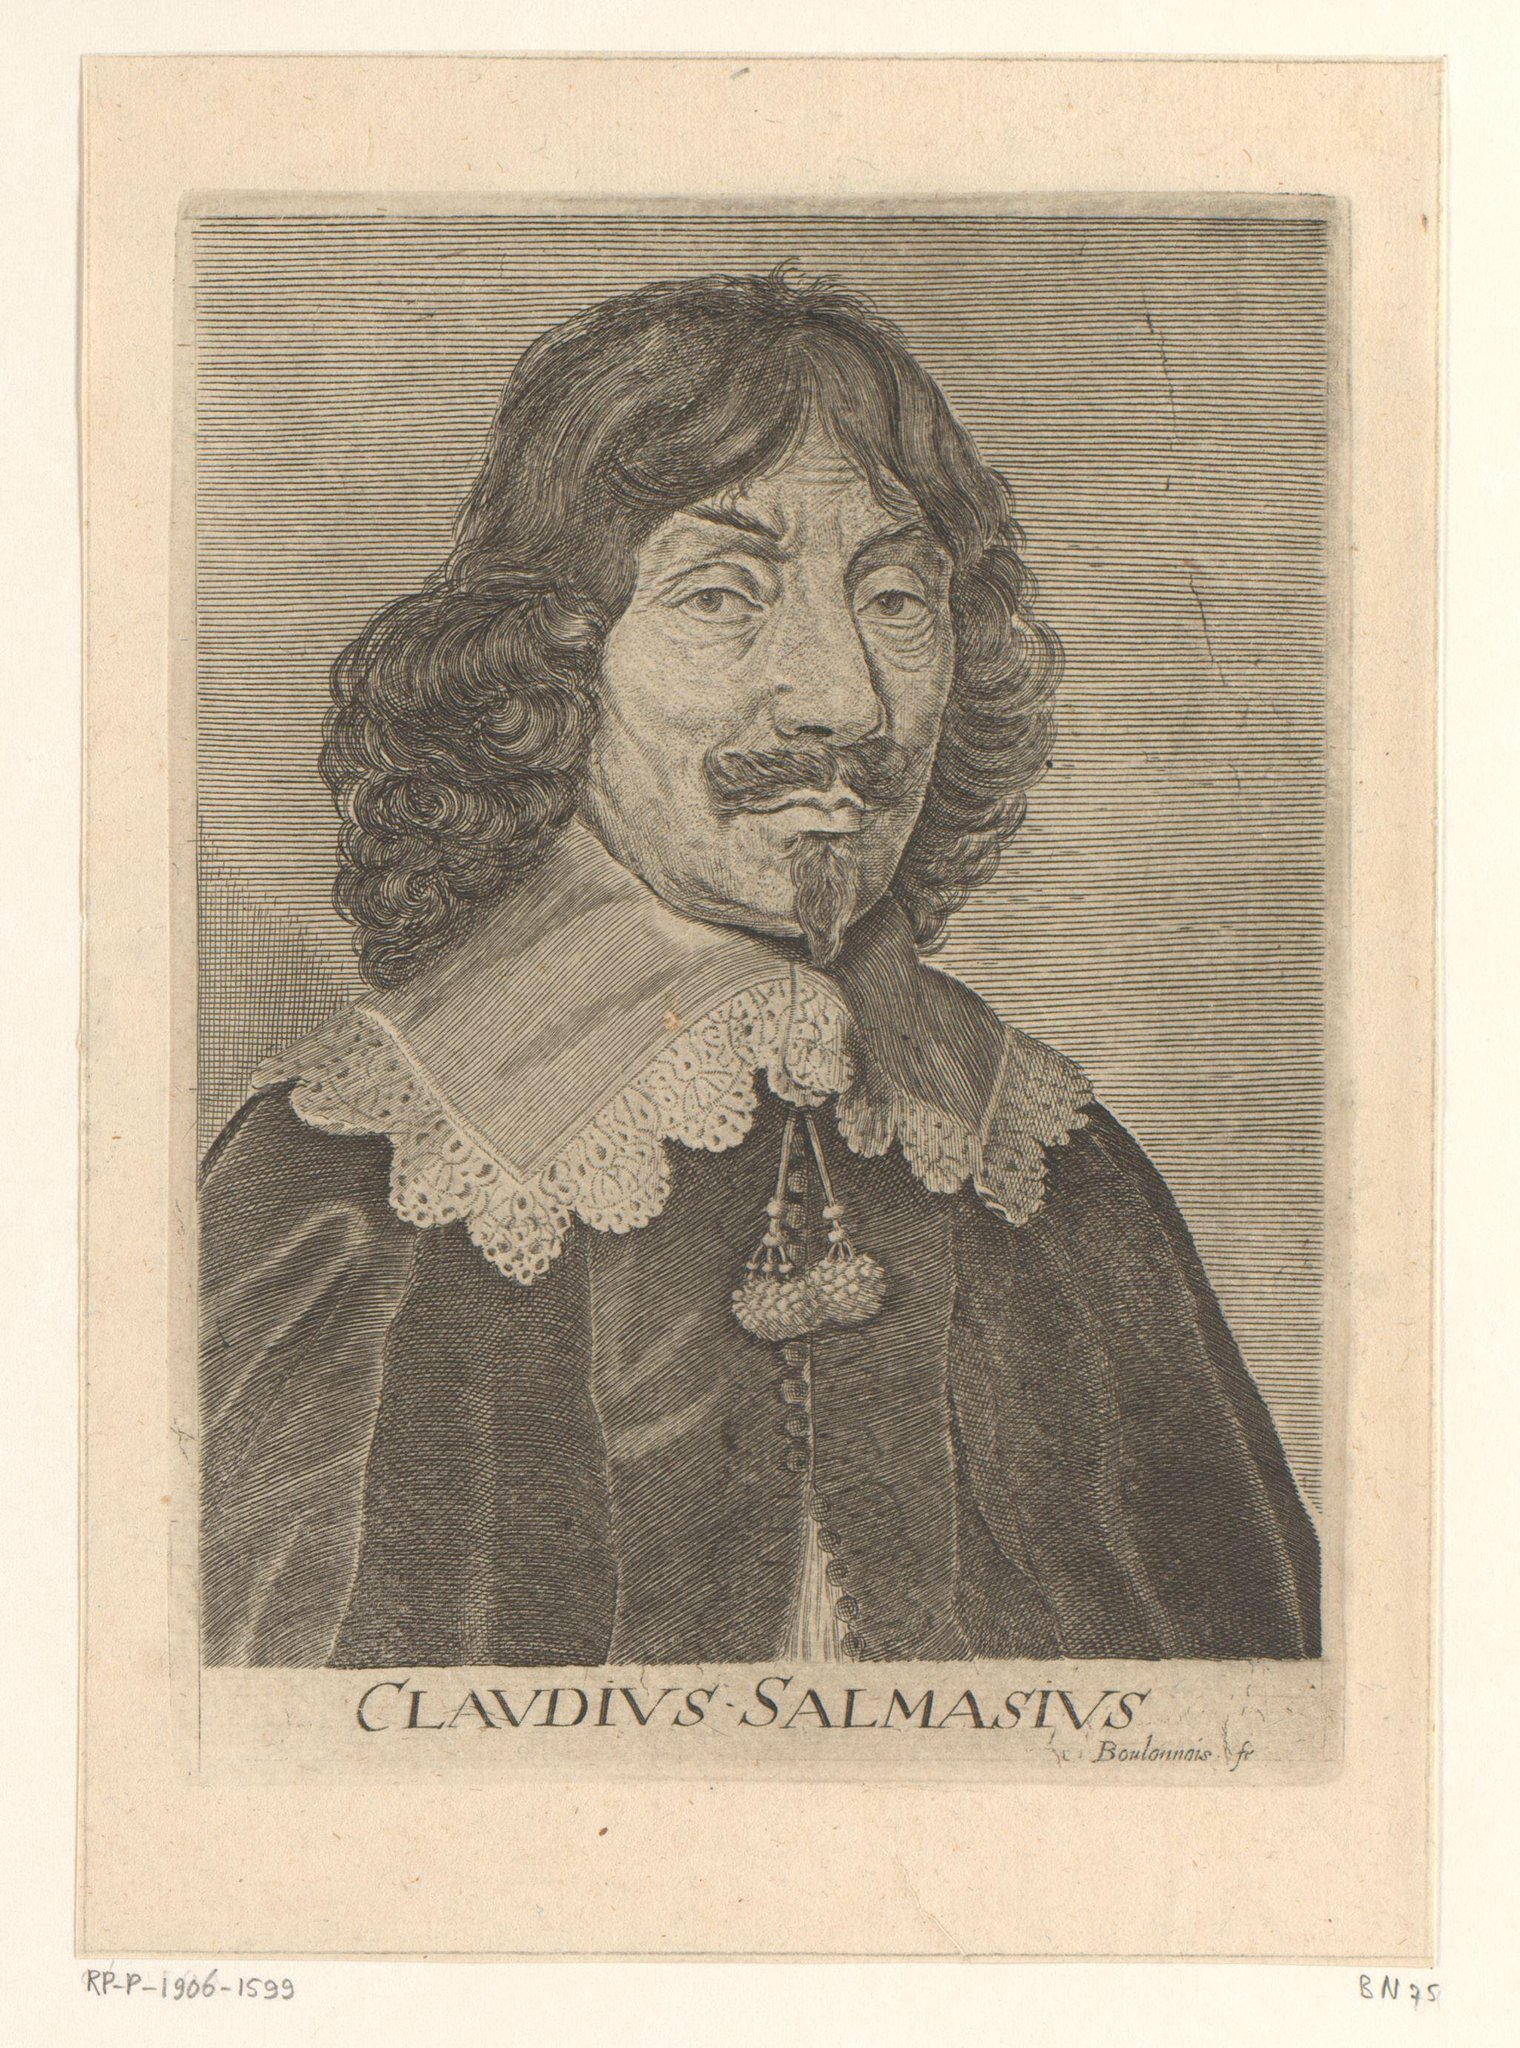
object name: book illustration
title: Claudius Salmasius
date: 1682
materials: paper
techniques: engraving, intaglio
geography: brussels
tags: claudius salmasius, scholar, philosopher, historical persons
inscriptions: collector's mark: Lugt 2228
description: Prent uit: Bullert, Isaac. Académie des Sciences et Arts contenant les vies et éloges his. des hommes illustres qui ont excellé en ces professions depuis environ quatre siècles. Brussel: Foppens, François, 1682. Het boek werd in 1682 eveneens in Amsterdam uitgegeven door de erfgenamen van Daniel Elzevier. Deze portretten dienen ter illustratie van de biografie van een kunstenaar of geleerde. De meeste portretten werden door Nicolas de Larmessin vervaardigd (162), 93 door De Boulonois en een derde door ongeïdentificeerde prentmakers. Dit betreft een illustratie op p. 226, deel II.